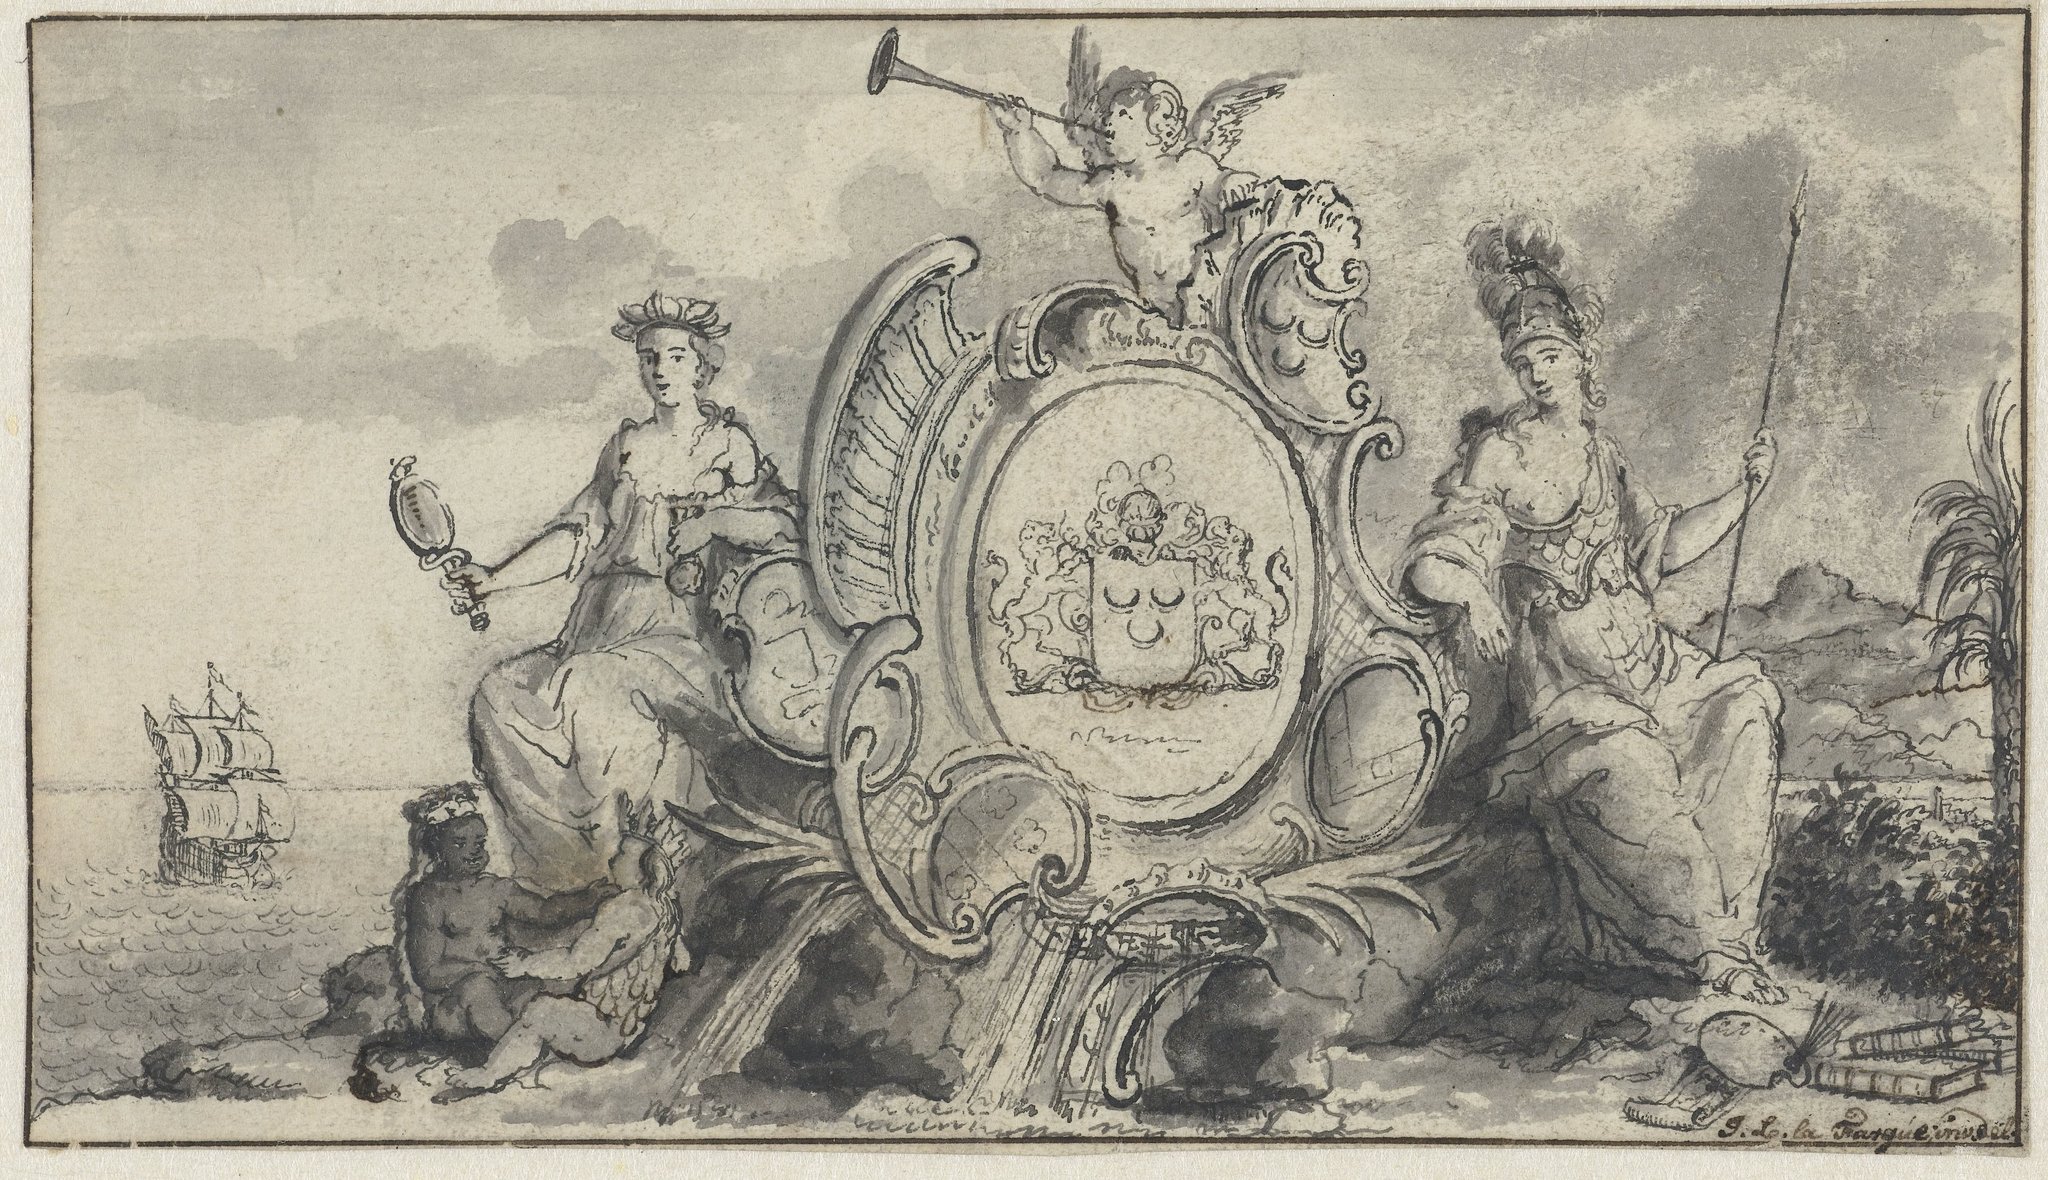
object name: drawing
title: Allegorische voorstelling met Prudentia, Minerva en twee kinderen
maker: isaac lodewijk la fargue van nieuwland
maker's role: draughtsman, painter, print maker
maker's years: 1726-1805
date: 1736-1805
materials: ink, paper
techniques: brush, pen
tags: education, science and learning, minerva as patroness, art, africa represented allegorically; 'africa' (ripa), america represented allegorically; 'america' (ripa)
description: Allegorische voorstelling: Prudentia en Minerva als beschermvrouwe van Kunst en Wetenschap; twee kindertjes als personificaties van Afrika en Amerika.